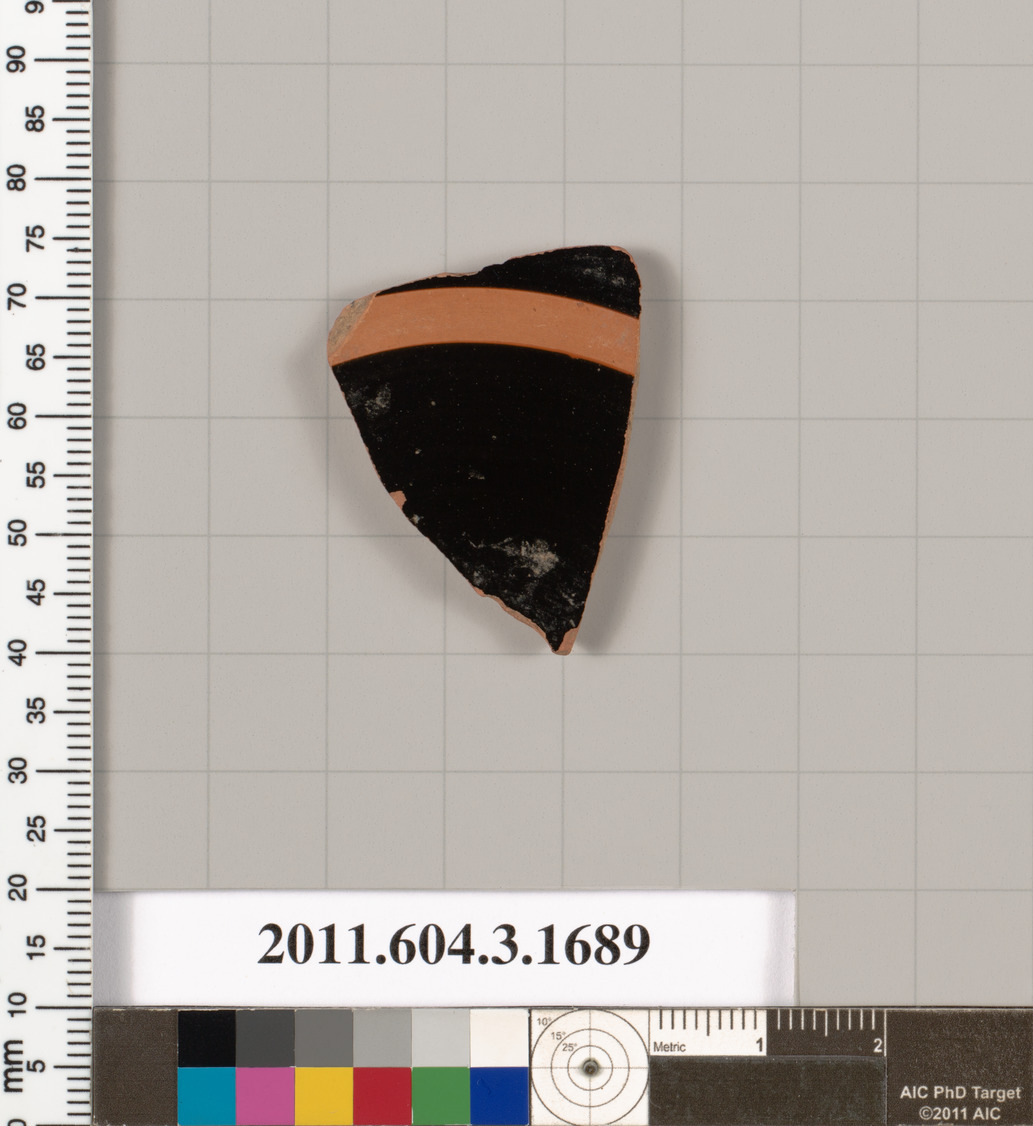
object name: kylix fragment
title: Terracotta fragment of a kylix: Band or lip cup (drinking cup)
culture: greek, attic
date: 550-526 BCE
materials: terracotta